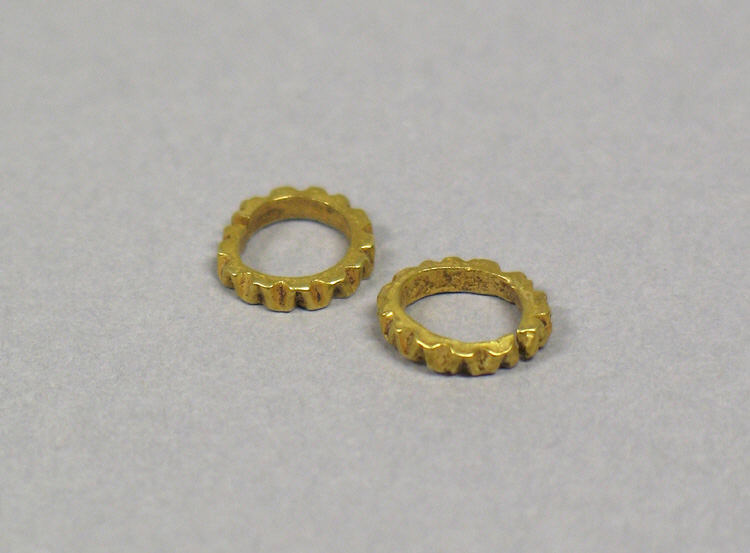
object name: pair of earring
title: Pair of Earrings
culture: indonesian, central java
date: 701-1200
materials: gold